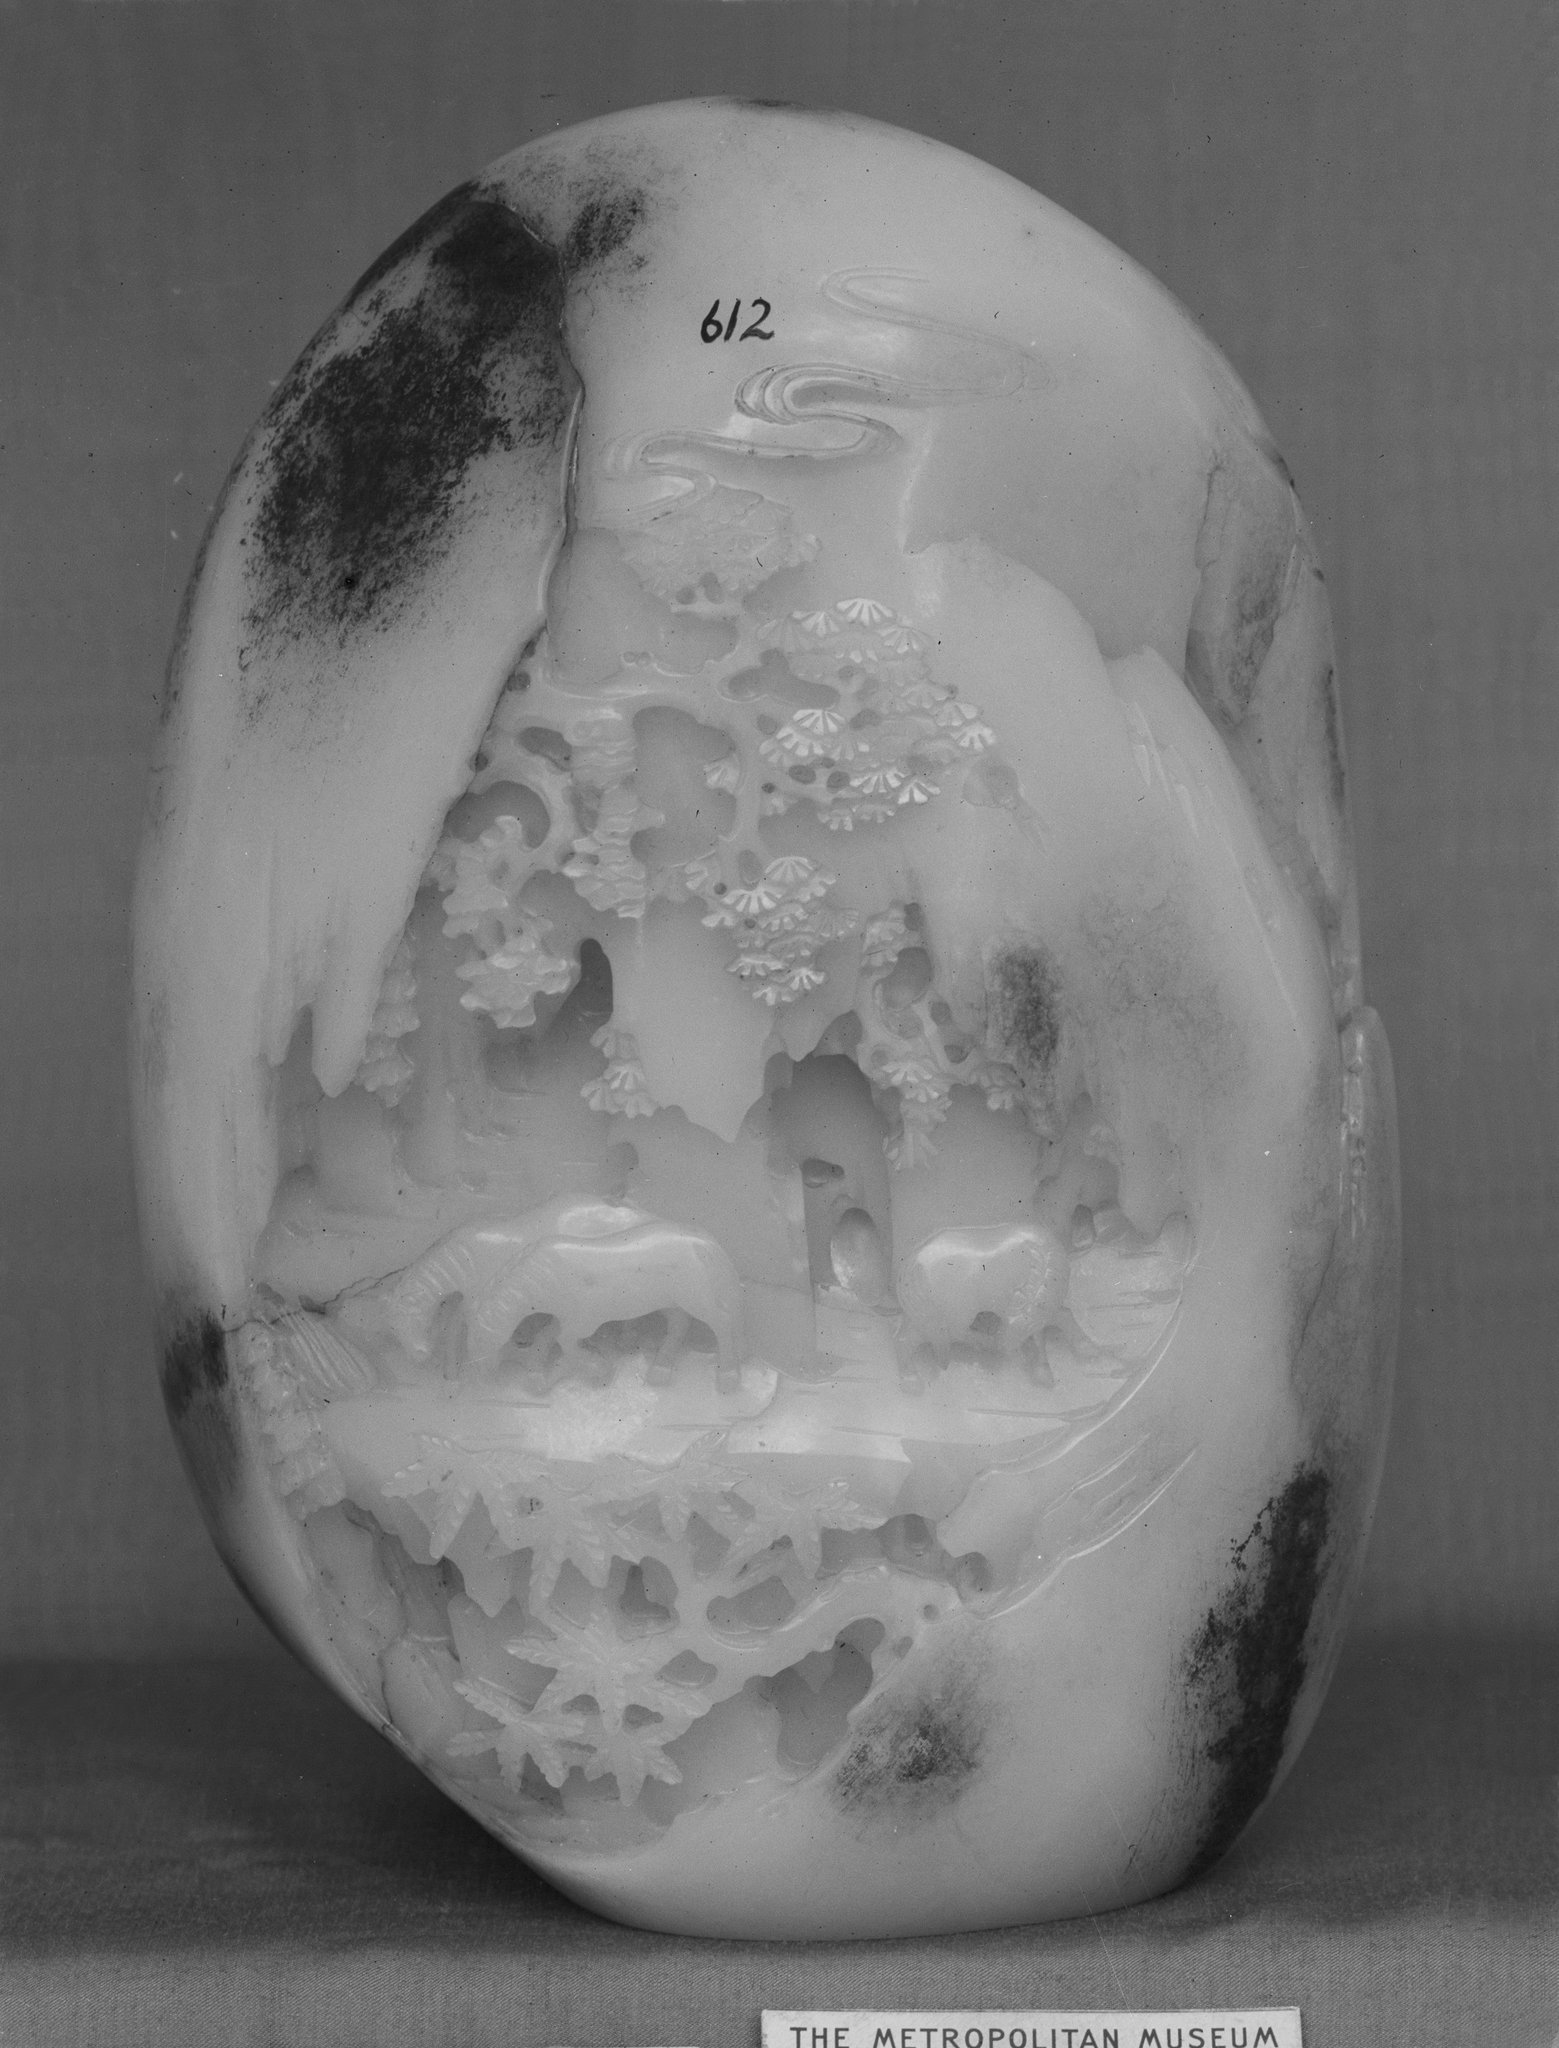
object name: boulder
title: Boulder with the eight horses of King Mu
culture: chinese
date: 1701-1800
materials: jade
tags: horses